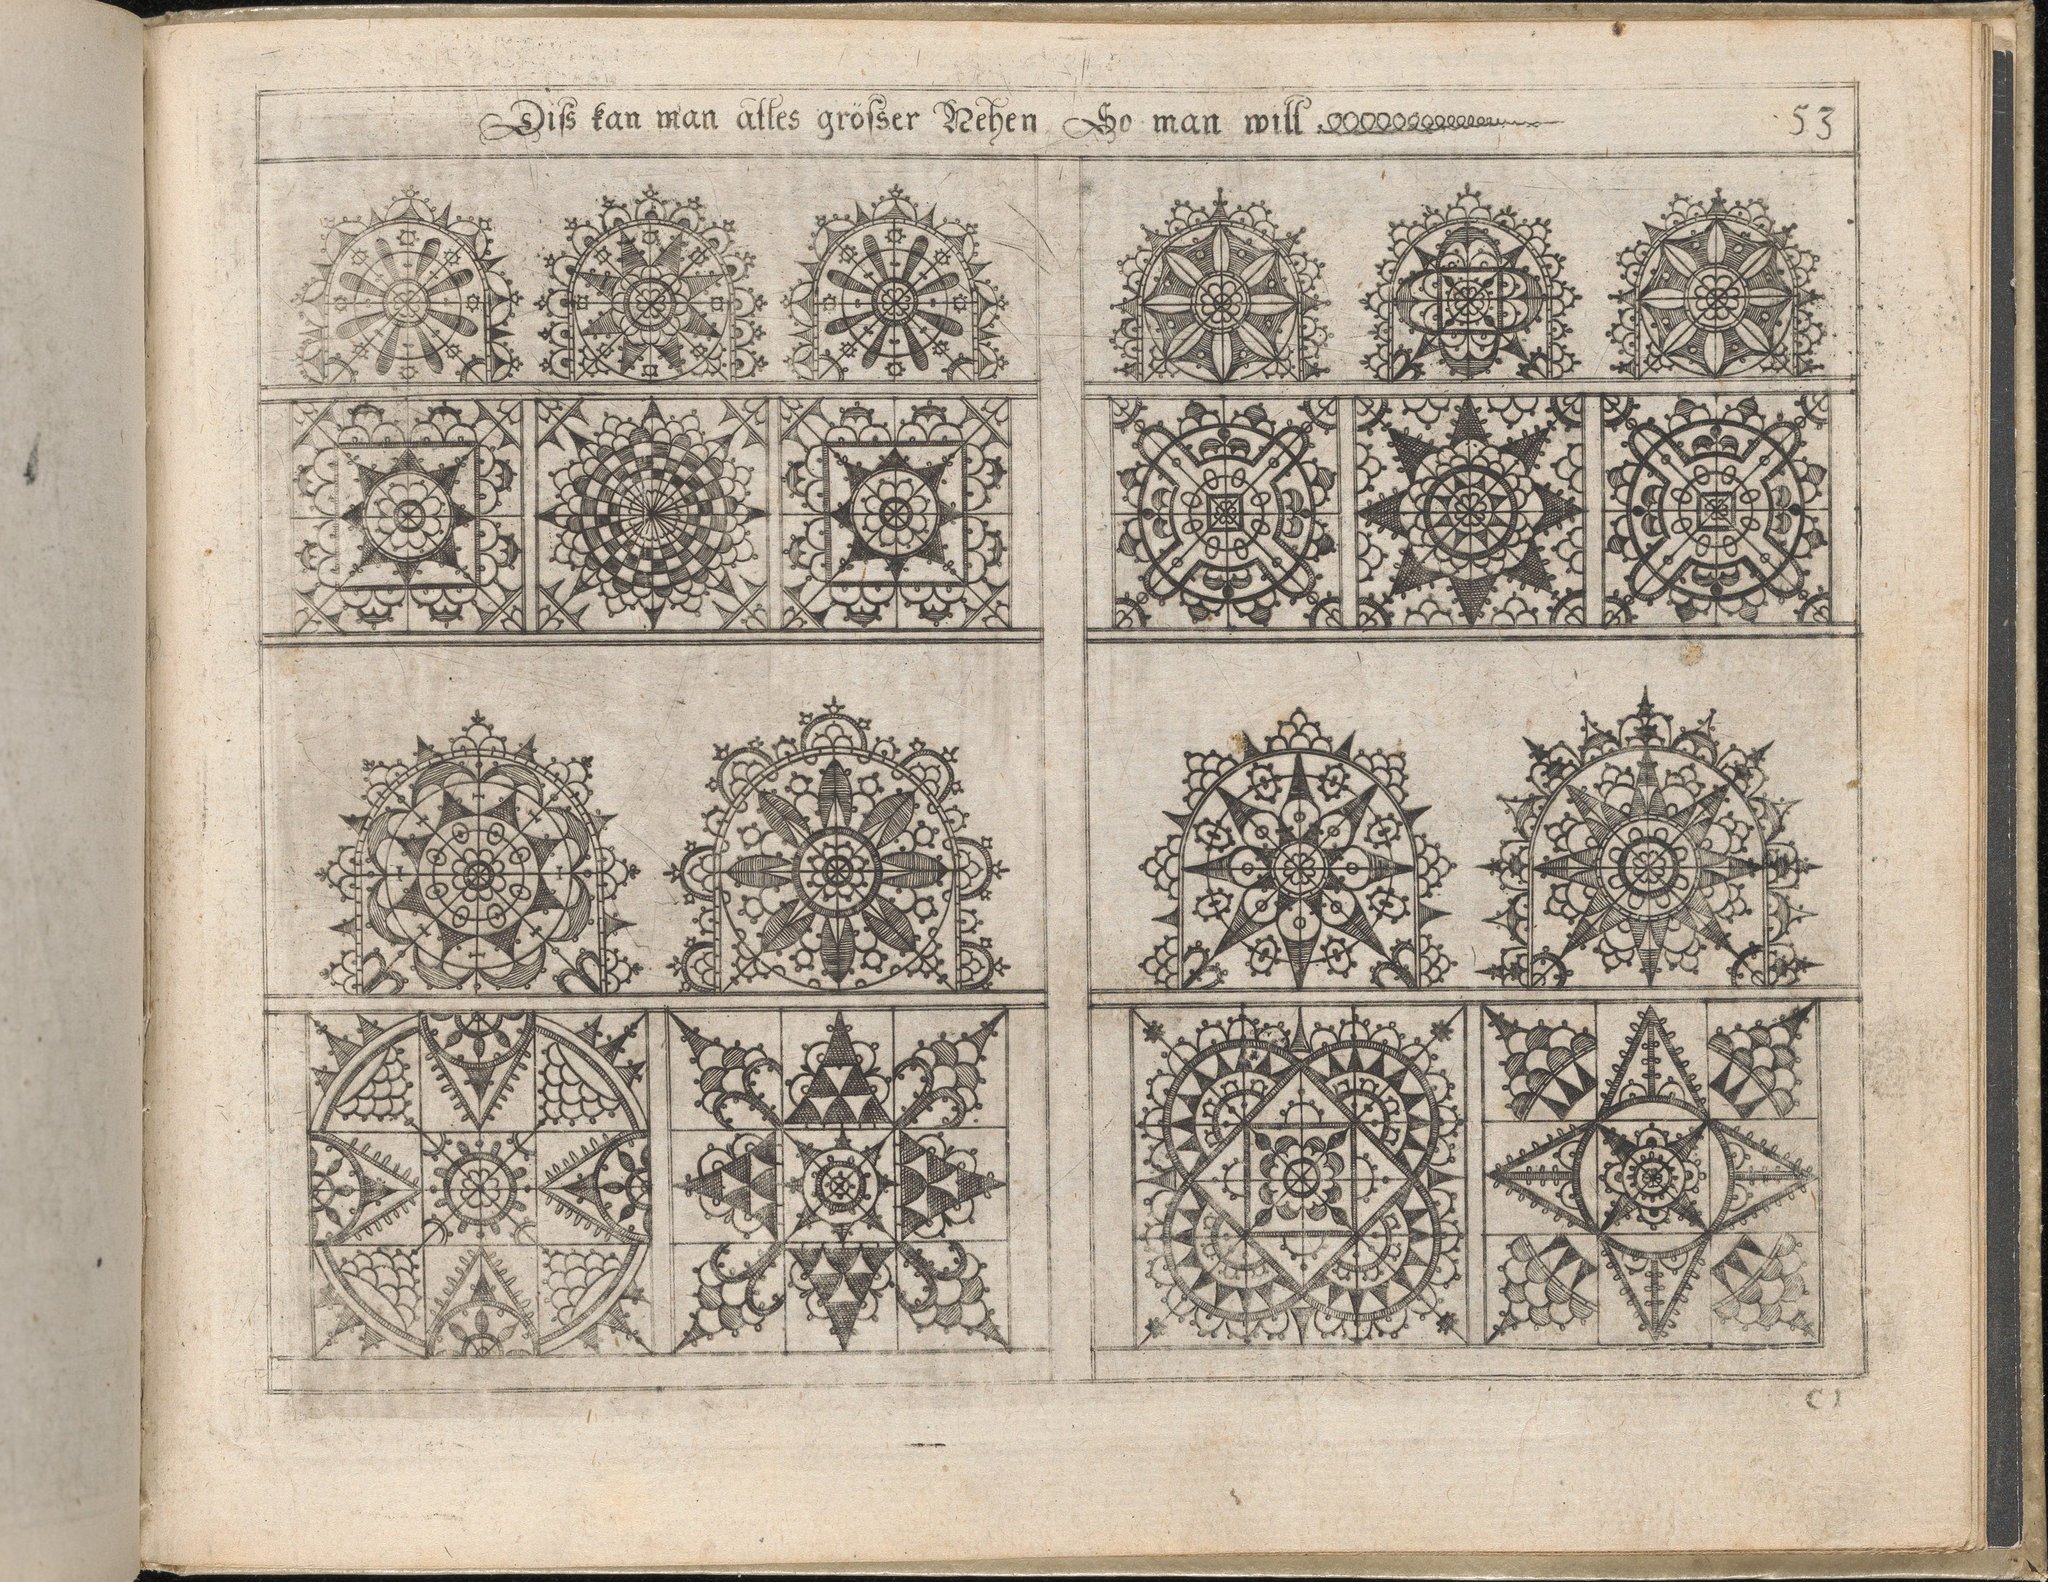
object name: book print ornament architecture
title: Newes Modelbuch in Kupffer (Page 61r)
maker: johann sibmacher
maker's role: artist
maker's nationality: german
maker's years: 1590-1611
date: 1604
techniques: etching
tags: ornament